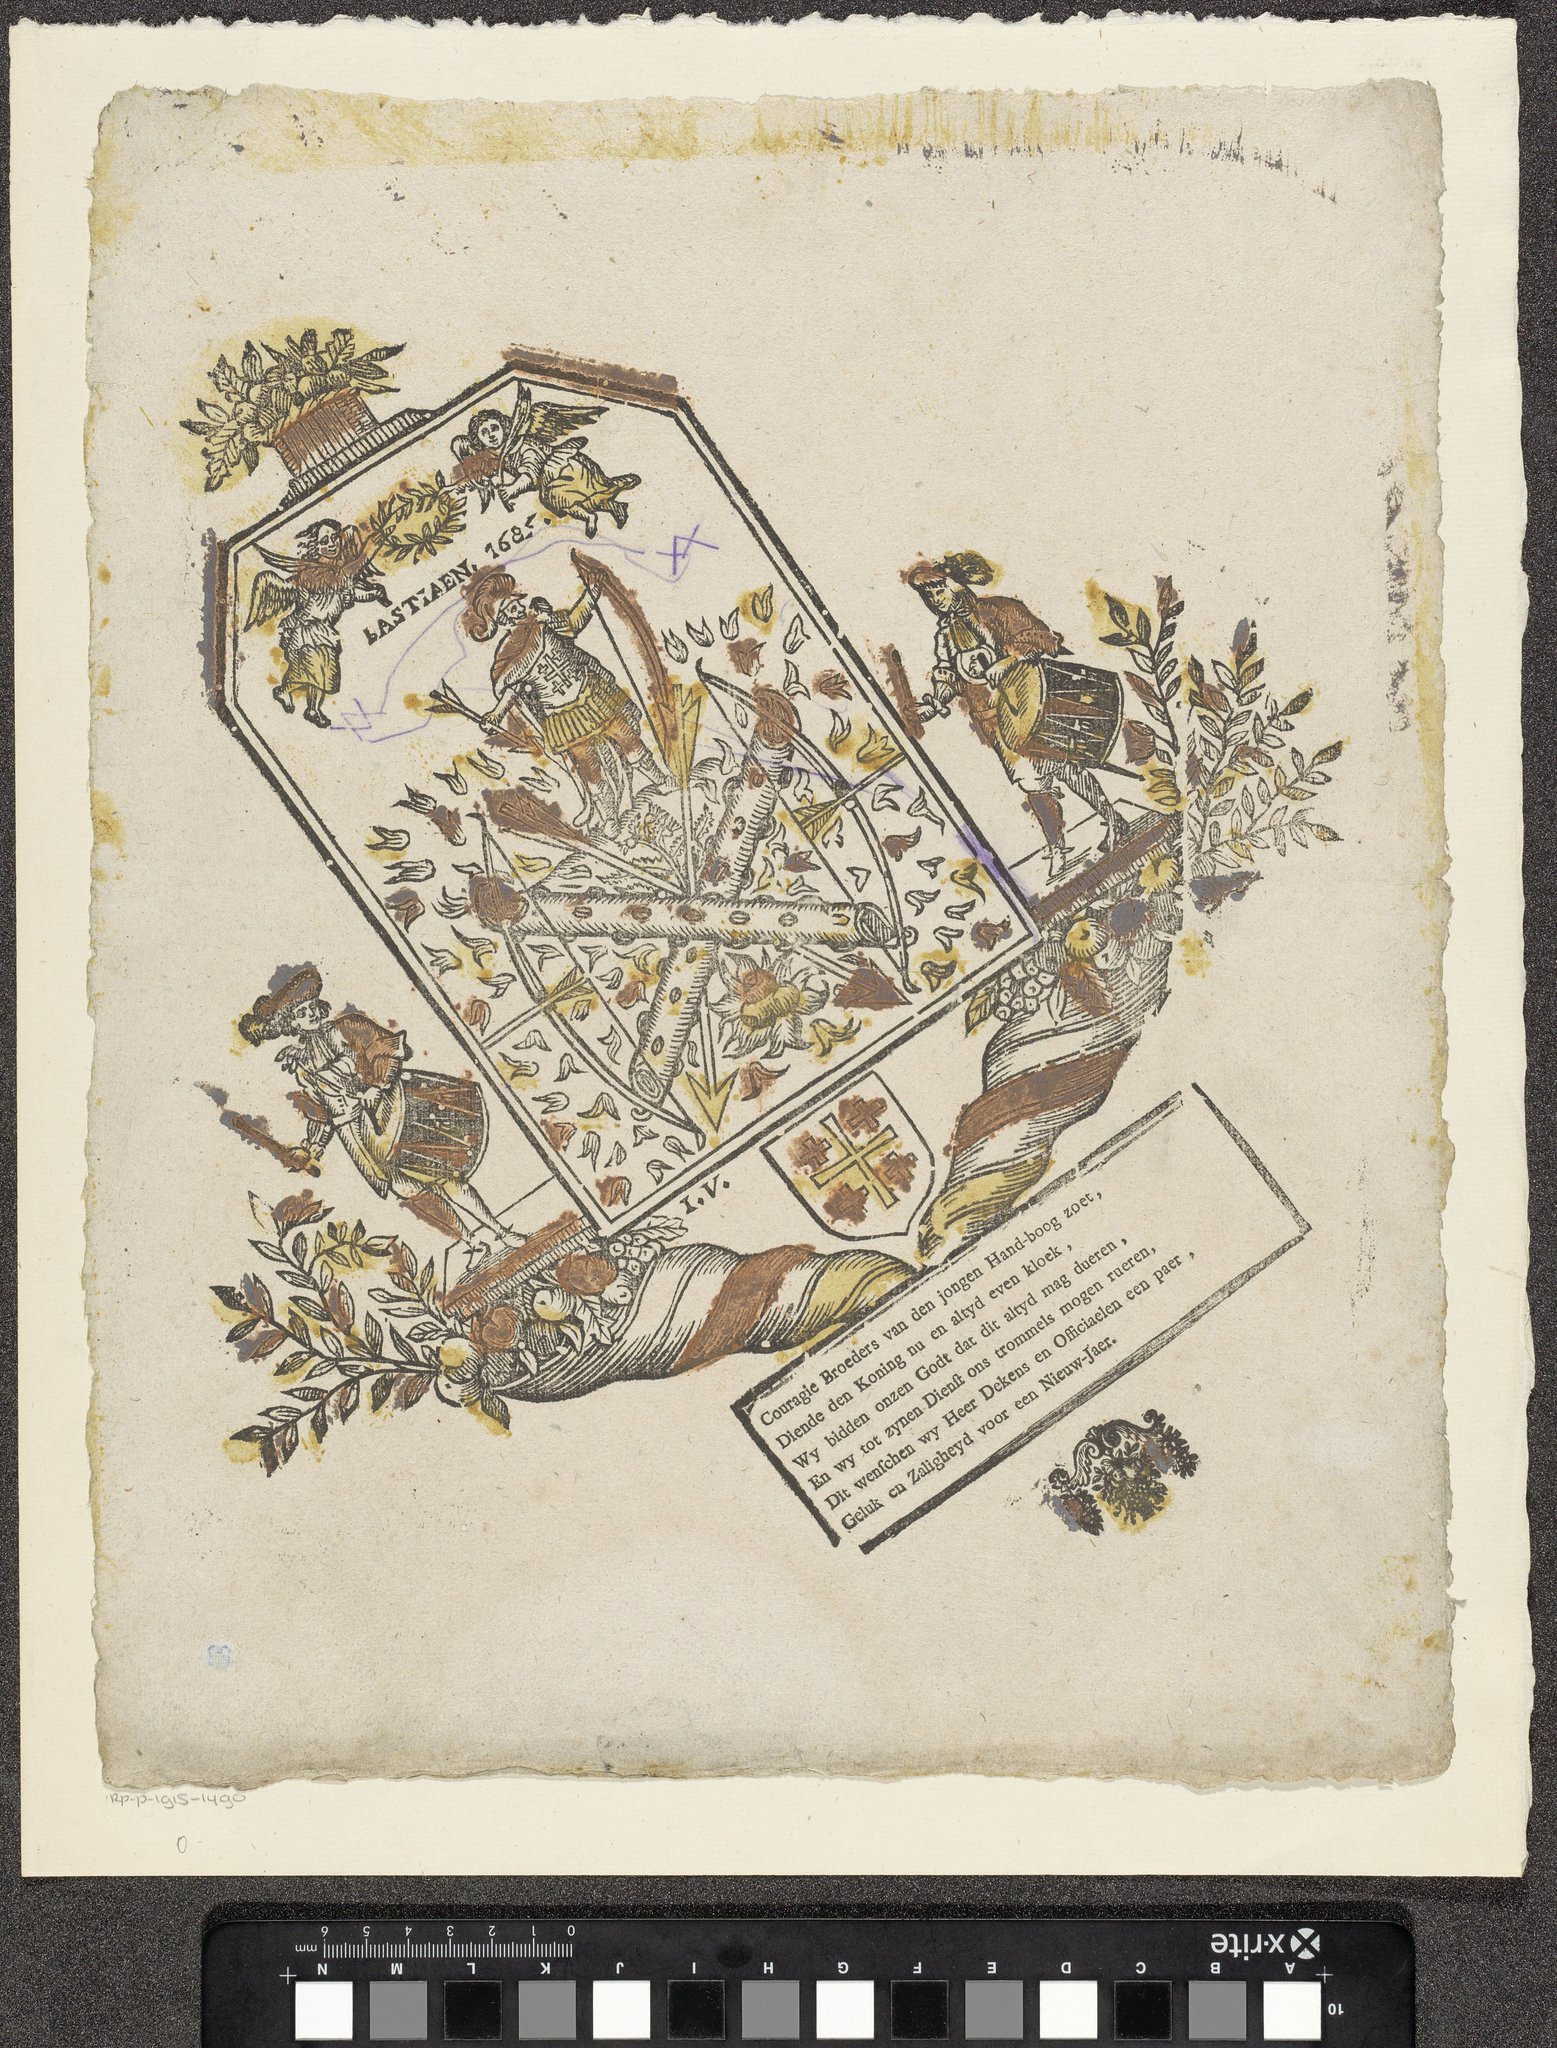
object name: new year card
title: Nieuwjaarswens van een boogschuttersgilde voor het jaar 1685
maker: monogrammist iv (graveur)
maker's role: print maker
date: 1685-1687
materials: paper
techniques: colour, letterpress printing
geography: netherlands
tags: corporative organization, guild, archer's weapons: bow and arrow, drum (musical instrument)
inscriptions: collector's mark: Lugt 2760, collector's mark: Lugt 2233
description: In het midden staat een boogdschutter op een aantal grote pijlen en bogen. Twee engelen houden een lauwerkrans boven zijn hoofd. Links en rechts staan mannen met trommels.